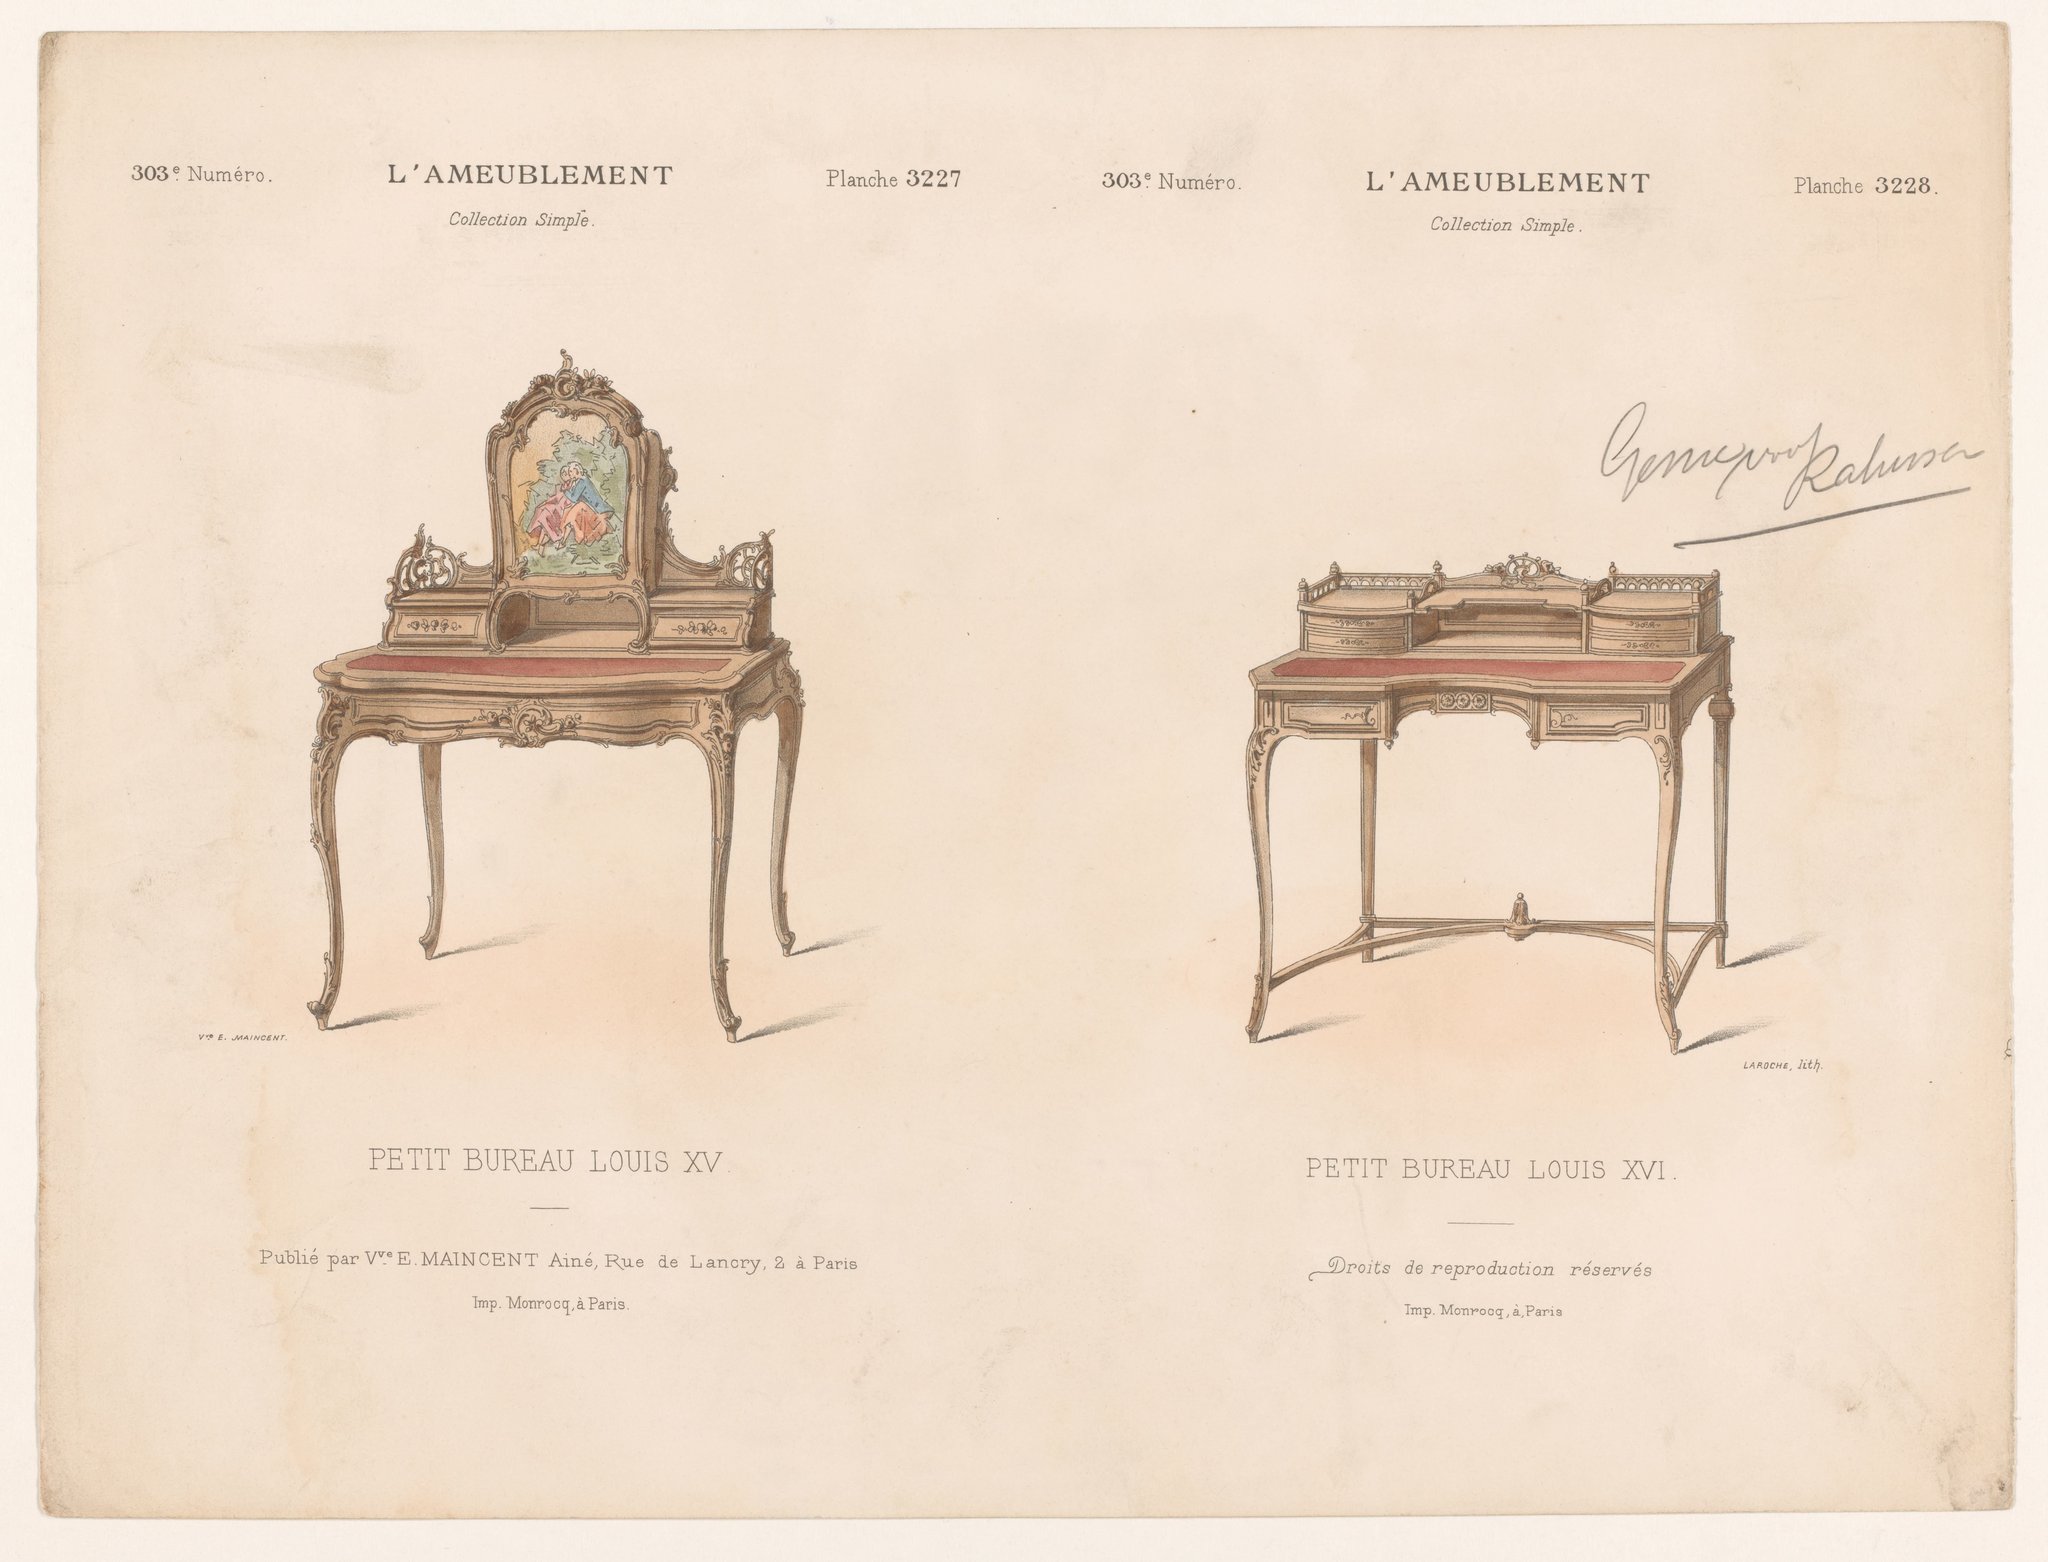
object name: print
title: L'ameublement / Collection simple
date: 1895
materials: paper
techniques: hand coloring, lithograph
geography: paris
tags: writing-table, writing-desk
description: Twee bureaus in de stijlen van Lodewijk XV en Lodewijk XVI. Prent uit 303e nummer (livraison).